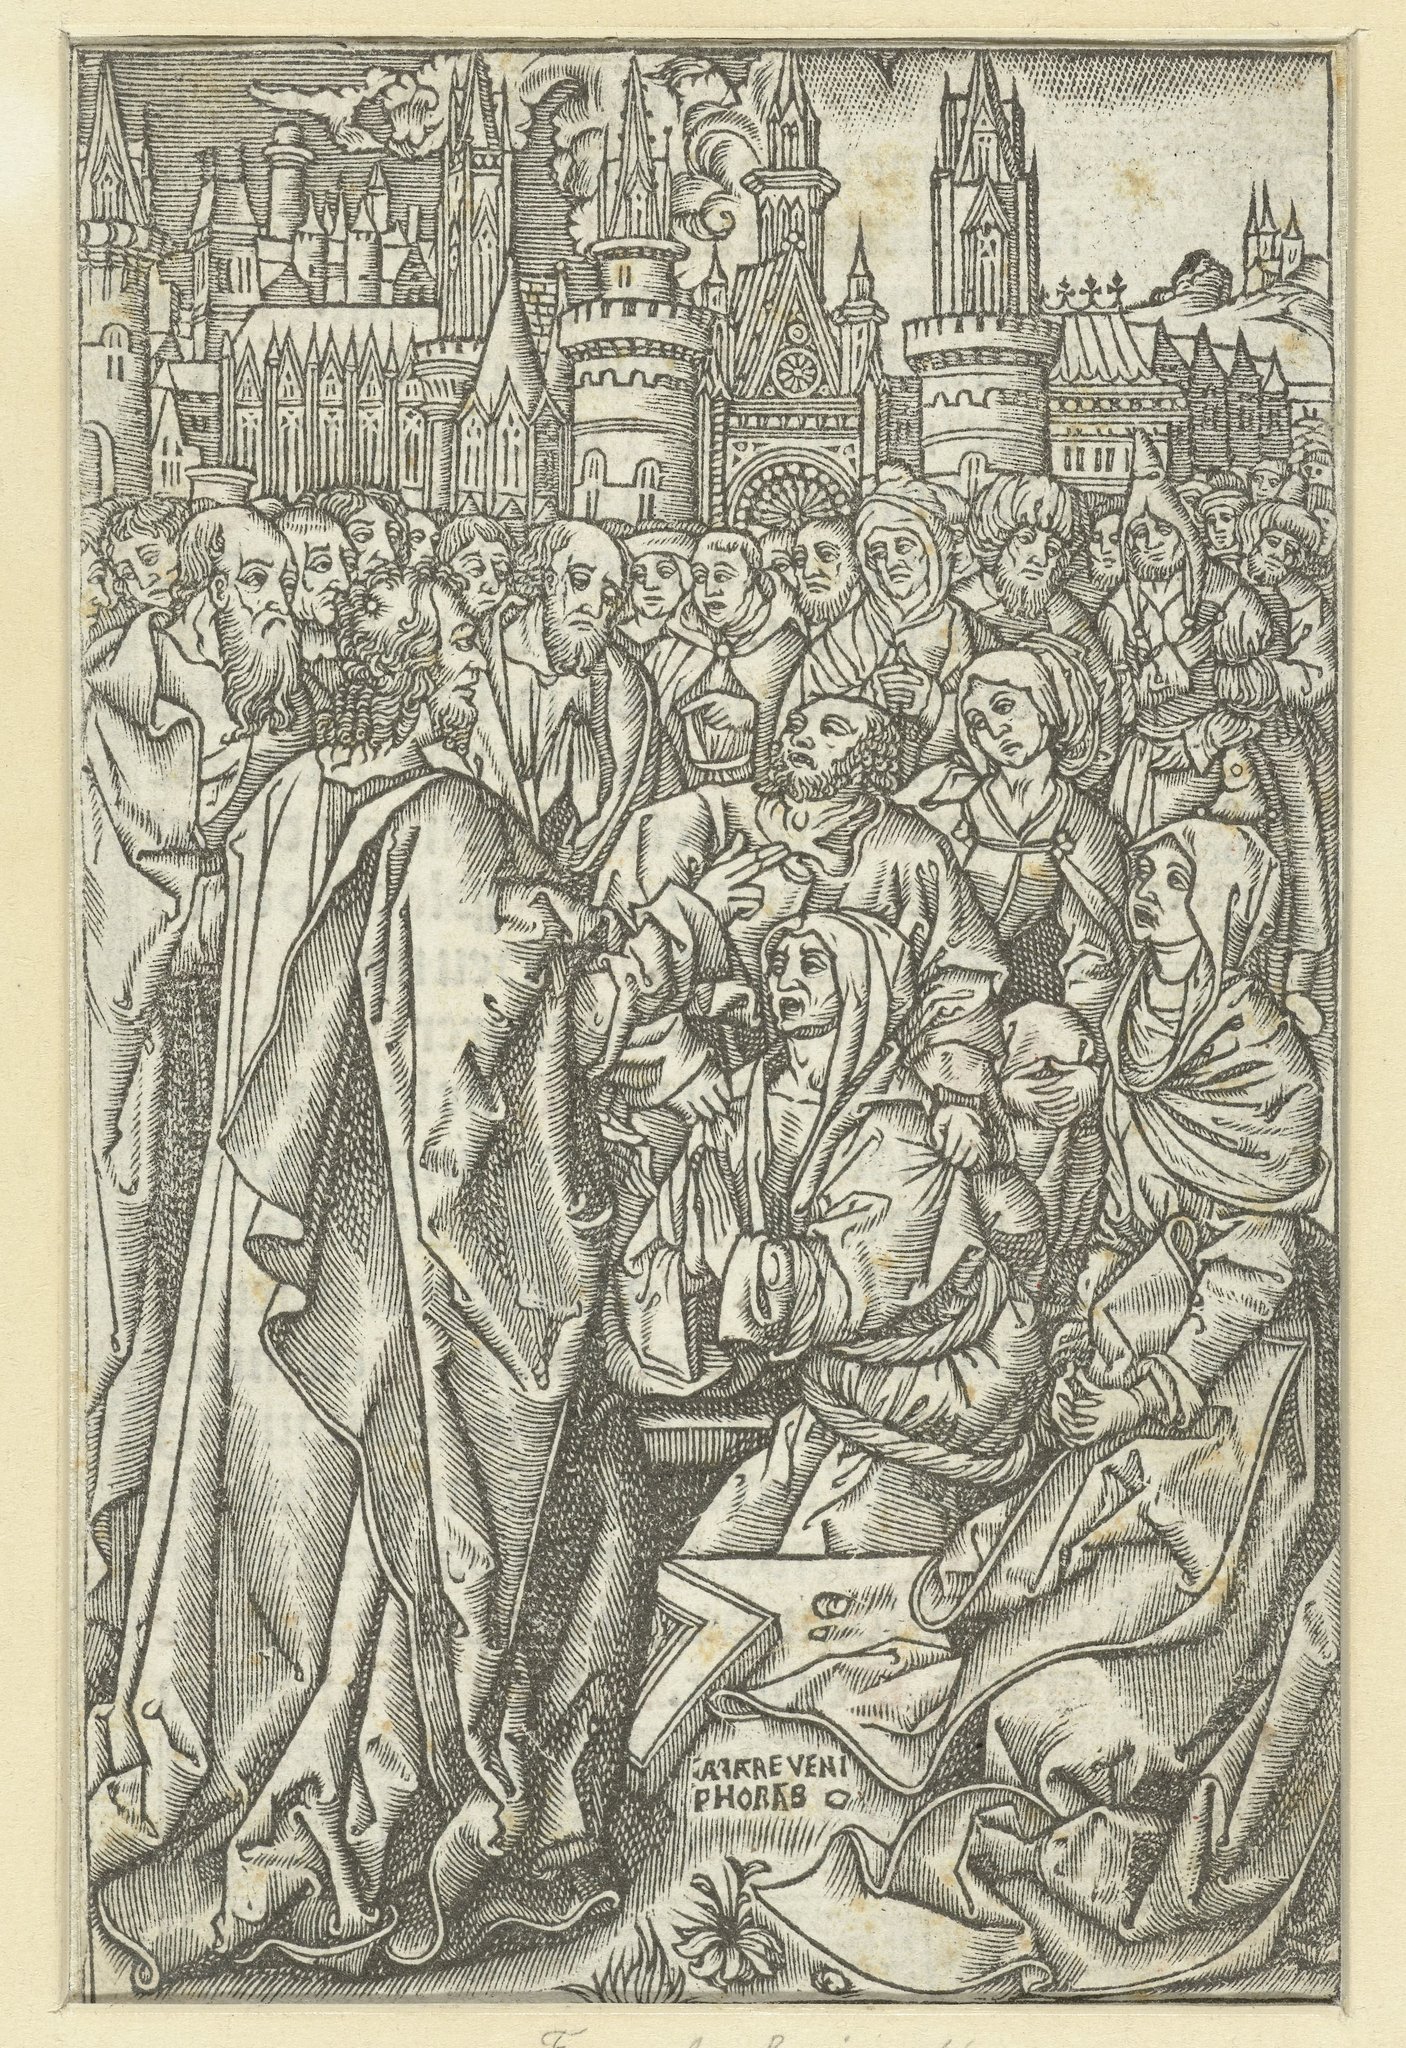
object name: book illustration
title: Het leven van Maria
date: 1507-1508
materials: paper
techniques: woodcut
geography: france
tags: the raising of lazarus ('lazarus, come out')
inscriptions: collector's mark: Lugt 240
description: Illustraties uit "Horae B. Mariae Virginis", uitgegeven door Thielman Kerver, Parijs 1508. Op verso tekst in het Latijn, gedrukt in zwart en rood. Langs de rand kleine voorstellingen (houtsneden). Botke, K.